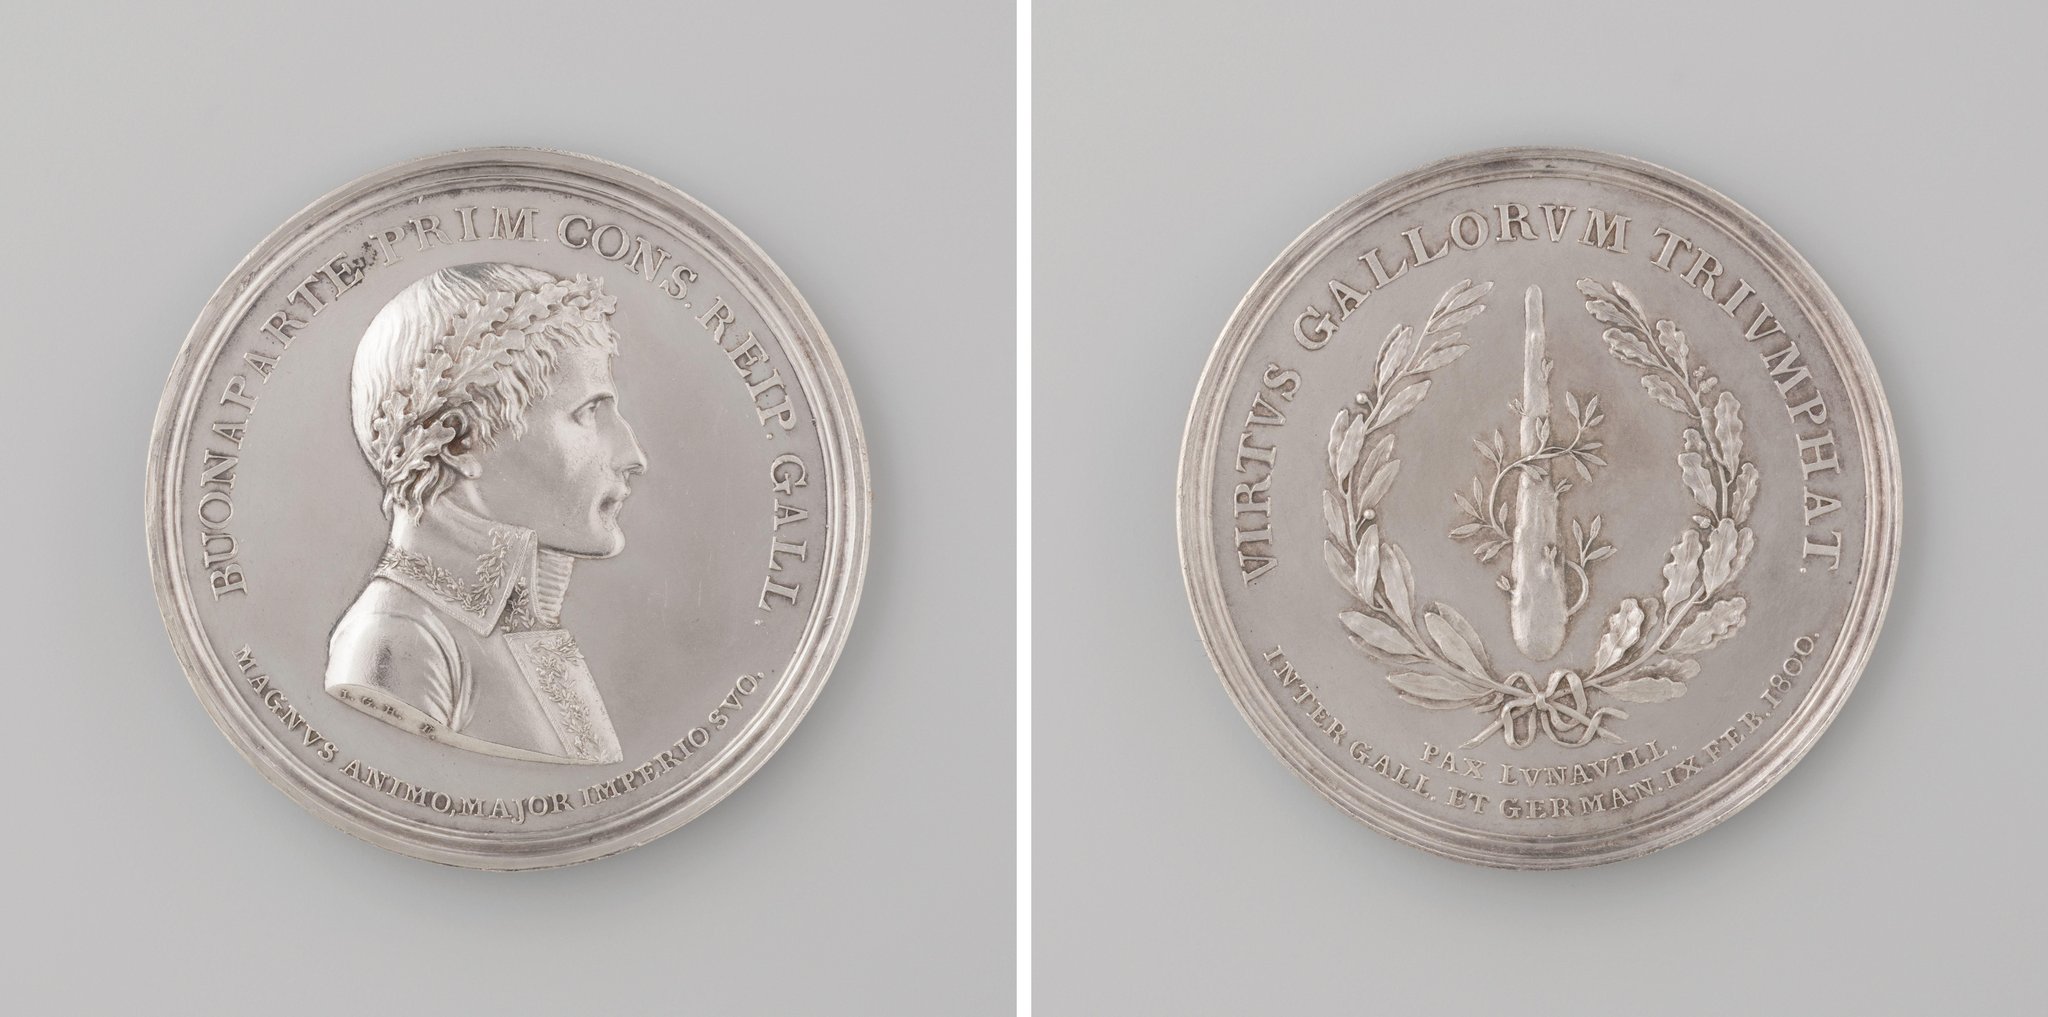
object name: history medal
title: Vrede van Luneville, ter ere van Napoleon Bonaparte, premier consul van Frankrijk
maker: johan george holtzhey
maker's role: mintmaster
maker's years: 1726-1808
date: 1801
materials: silver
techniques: striking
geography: amsterdam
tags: napoleon i (emperor of the french)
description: Zilveren penning. Voorzijde: borststuk man binnen omschrift. Keerzijde: knots, waar jonge spruit uitgroeit binnen eikenkrans en omschrift